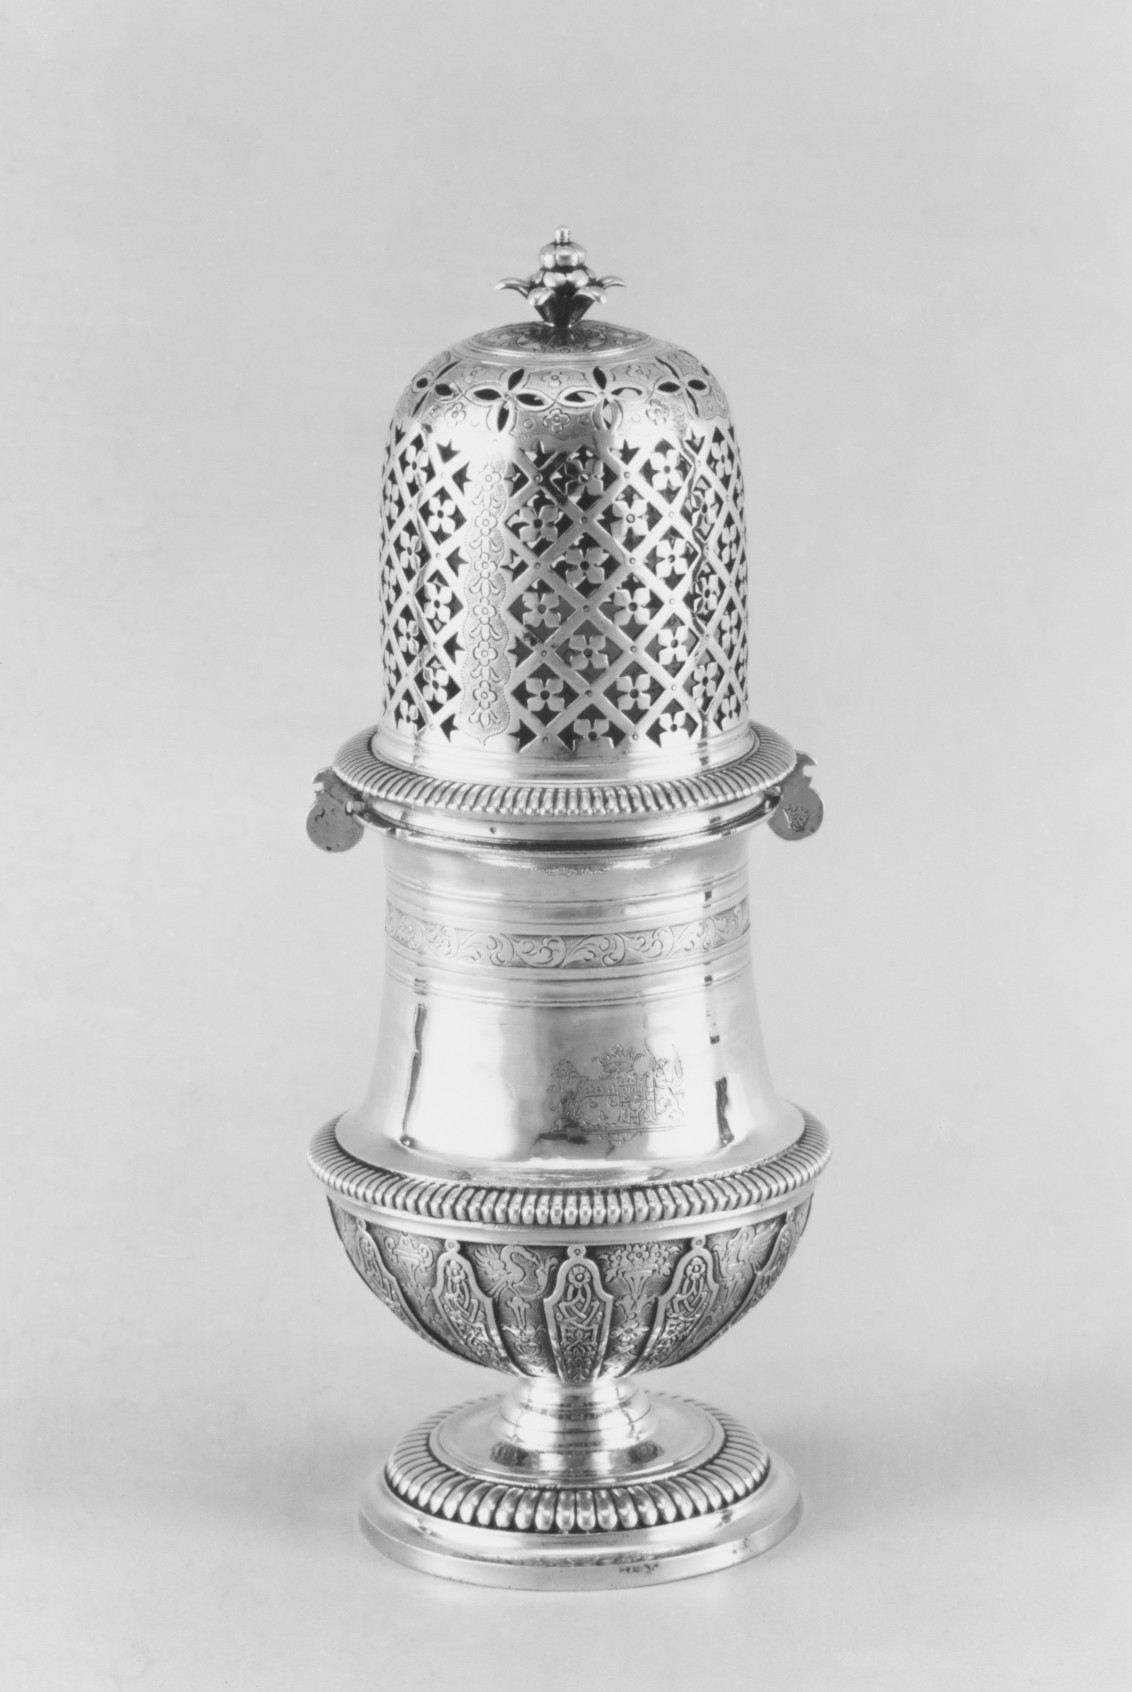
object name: sugar caster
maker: david andré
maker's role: maker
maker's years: 1643-1743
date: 1709-1710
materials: silver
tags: coat of arms